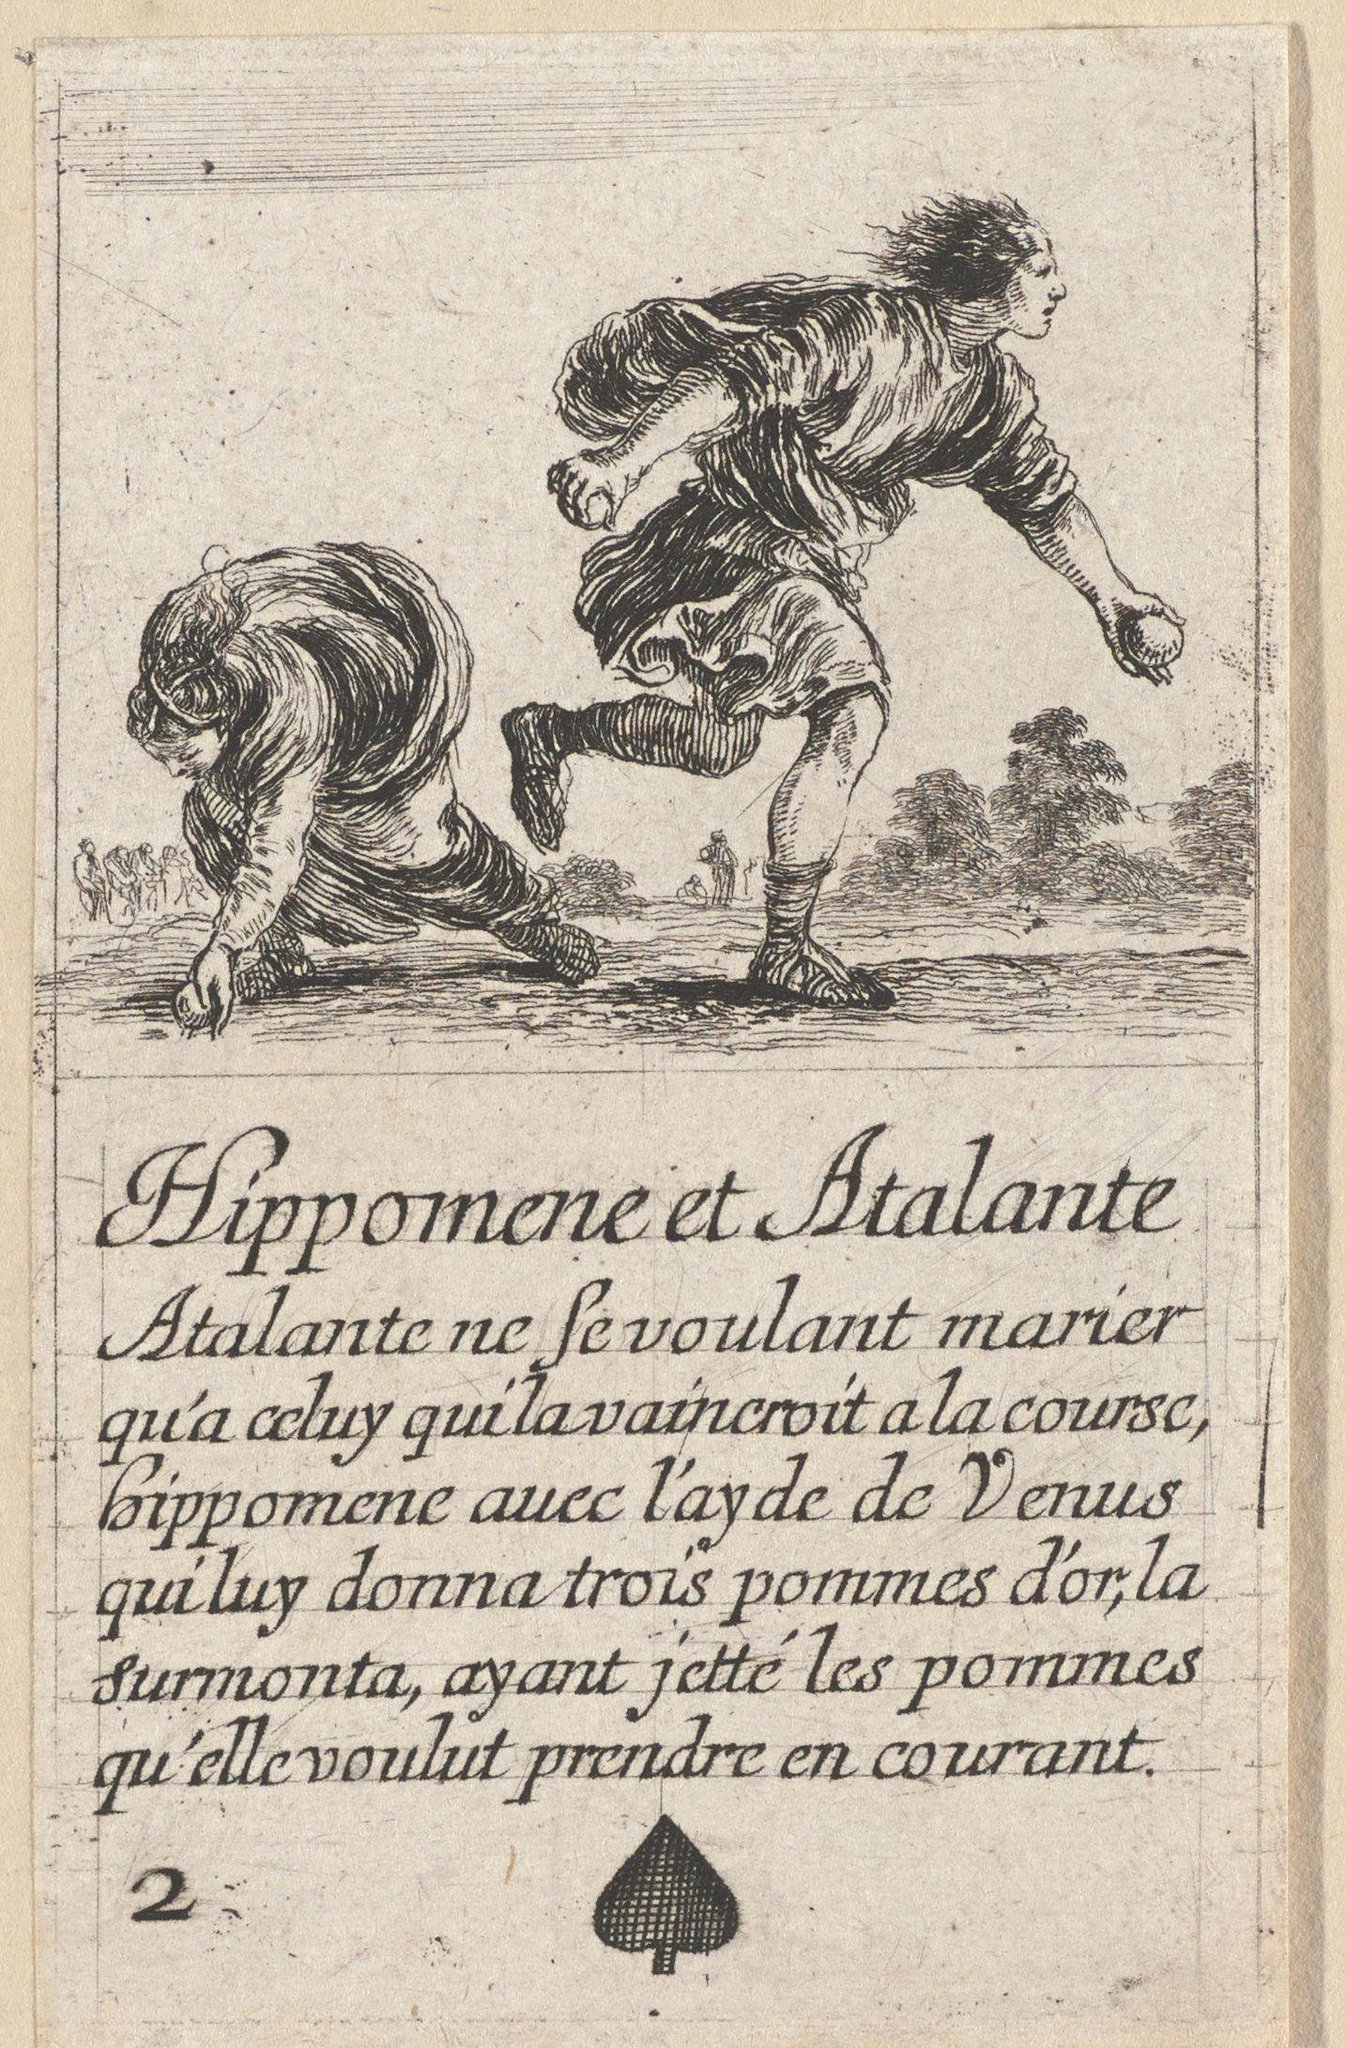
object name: print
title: Schoppen twee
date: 1620-1664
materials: paper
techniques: etching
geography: paris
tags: atalante and hippomenes (or meilanion)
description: Deze prent maakt deel uit van een kaartspel met 52 kaarten met voorstellingen uit de Metamorfosen van Ovidius. De serie is uitgedacht door Jean Desmarests de Saint-Sorlin in opdracht van Kardinaal Mazarin. Het kaartspel werd gemaakt voor de jonge Lodewijk XIV, samen met het Jeu des Reynes Renommées, Jeu de la Géographie en Jeu des Rois de France.